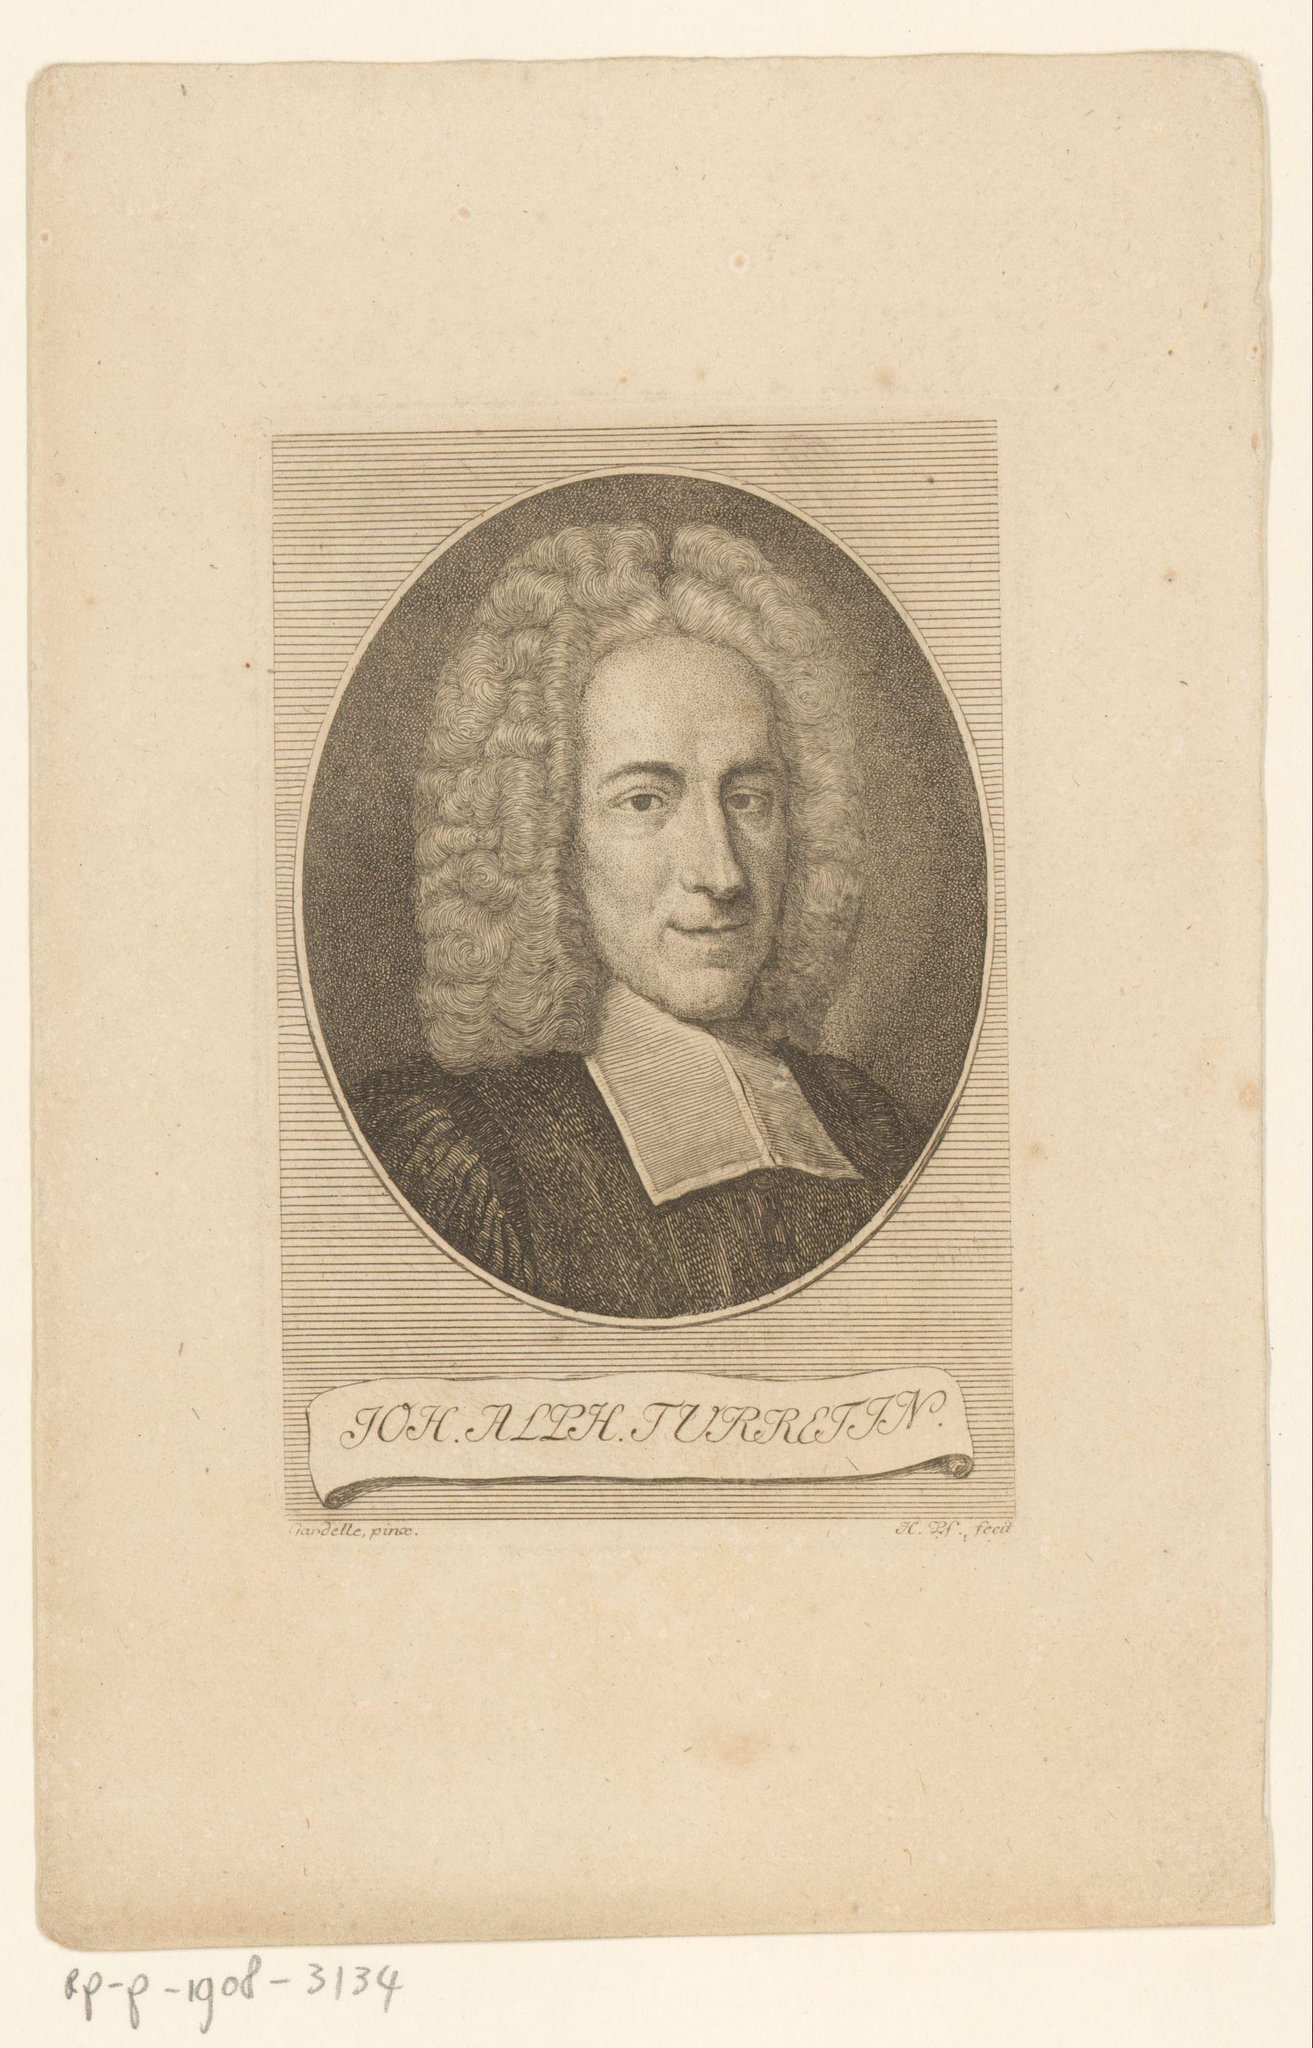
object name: print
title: Portret van Jean-Alphonse Turrettini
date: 1759-1815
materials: paper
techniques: etching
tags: historical persons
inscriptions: collector's mark: Lugt 2228